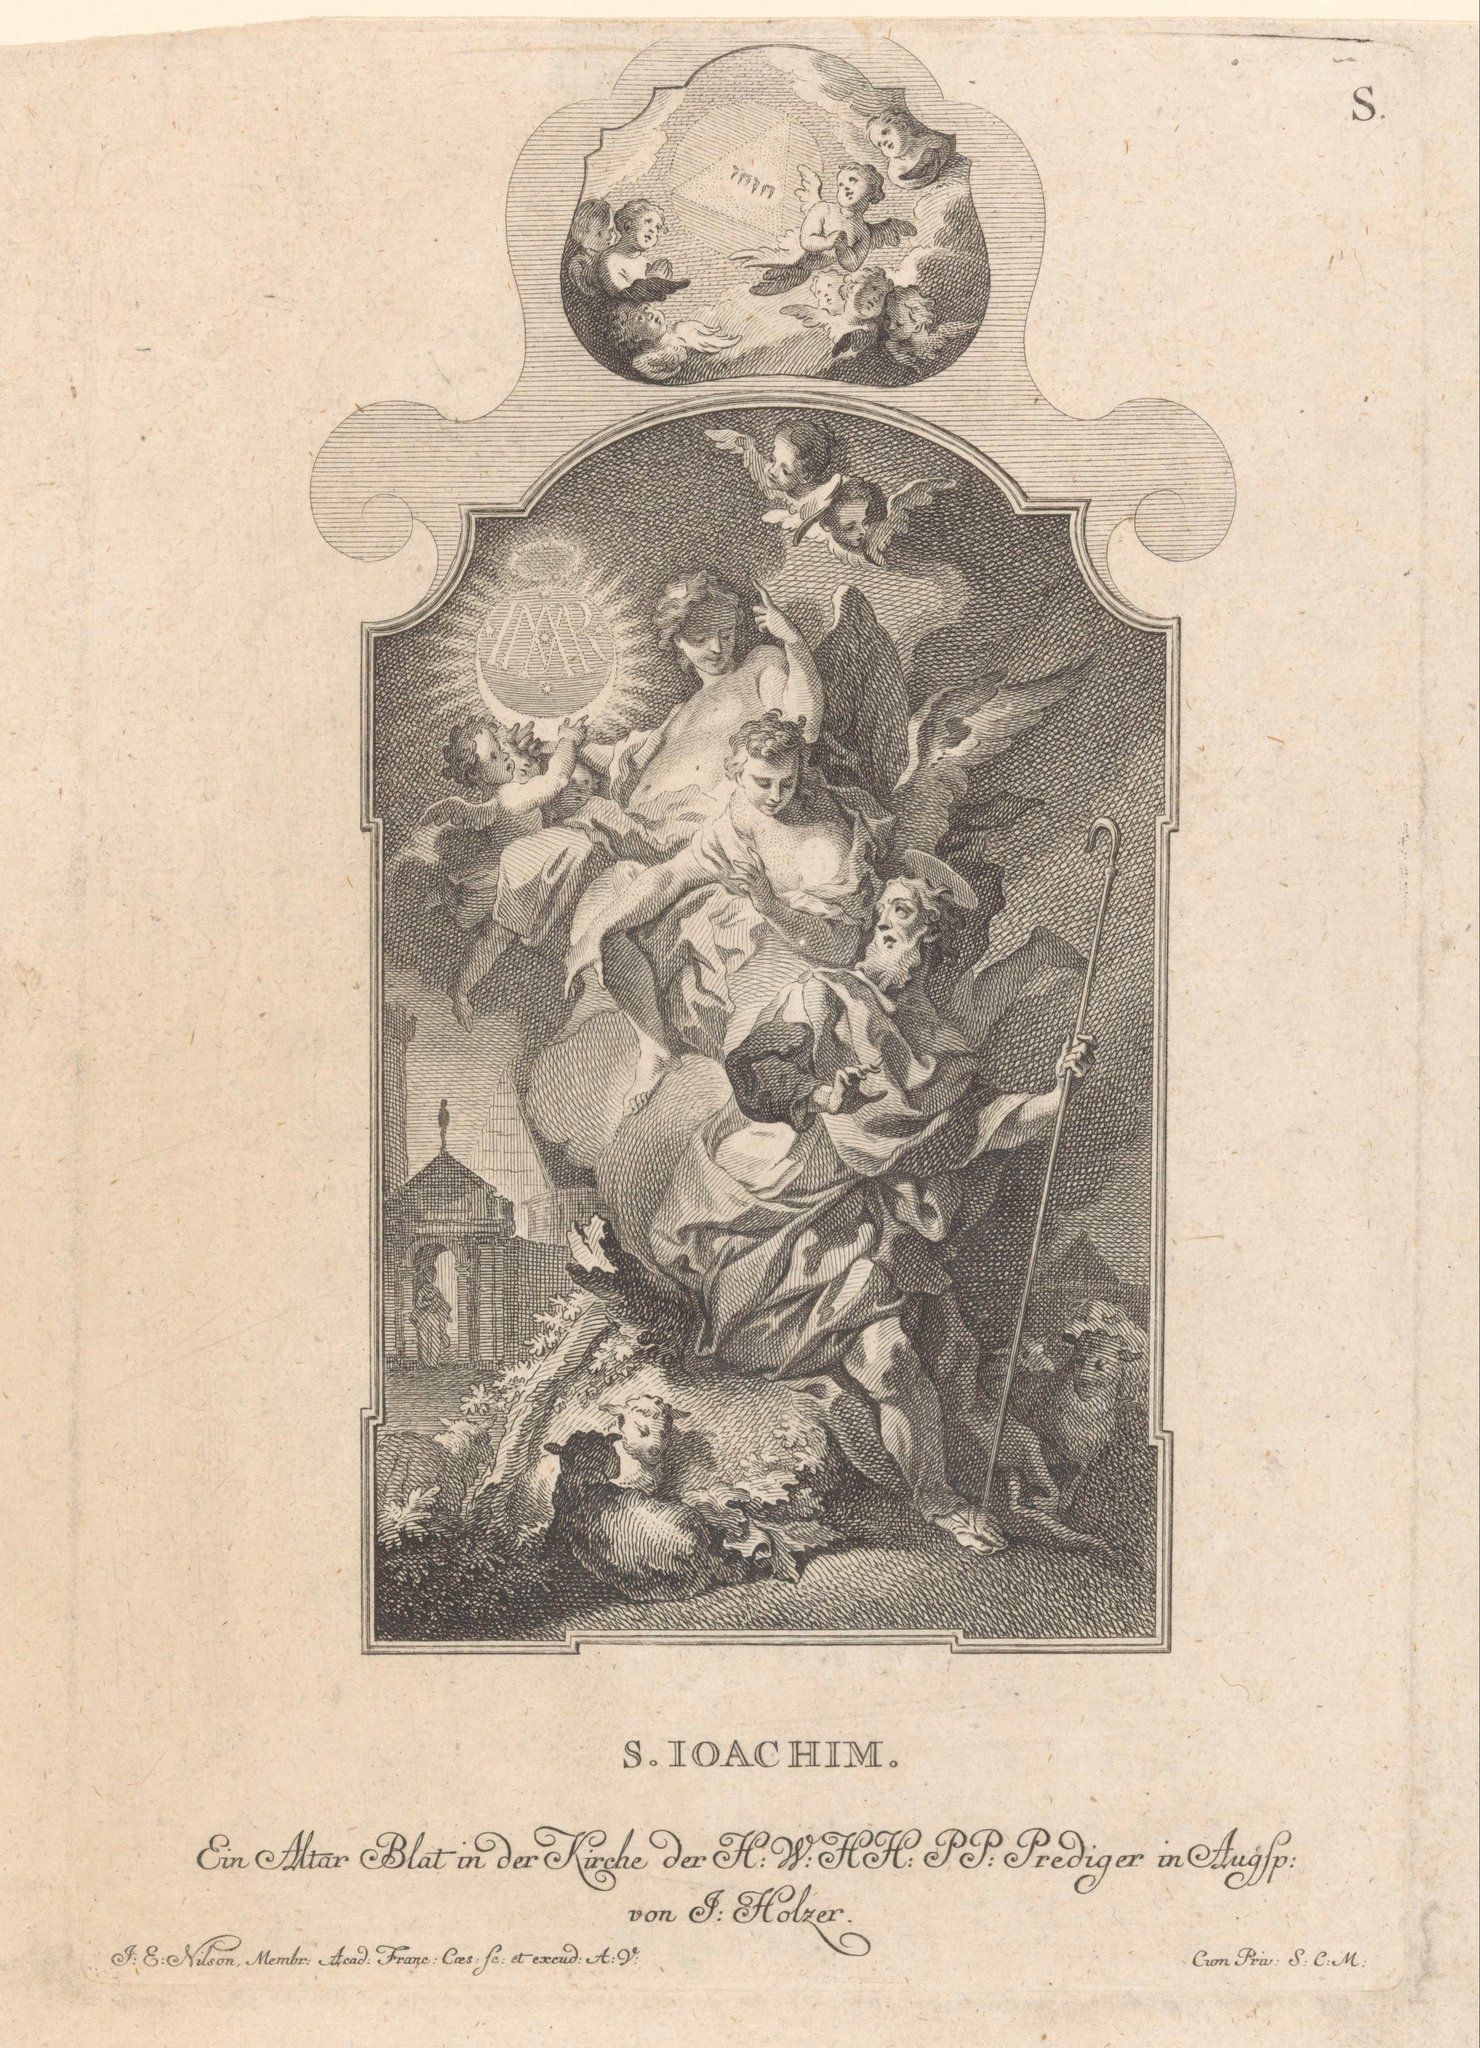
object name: print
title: S. S. Ioachim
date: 1765-1770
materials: paper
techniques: engraving, etching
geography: augsburg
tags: annunciation of the birth of mary to joachim by an angel, tetragram (in roman or hebrew script) ~ symbol of god the father, monograms of mary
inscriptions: collector's mark: Lugt 2760, collector's mark: Lugt 2228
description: De aankondiging van de geboorte van Maria aan Joachim door twee engelen. Twee putti houden het monogram van Maria vast. In het landschap links in de achtergrond staat Anna bij een poort. Boven de voorstelling gevleugelde putti met het tetragram.